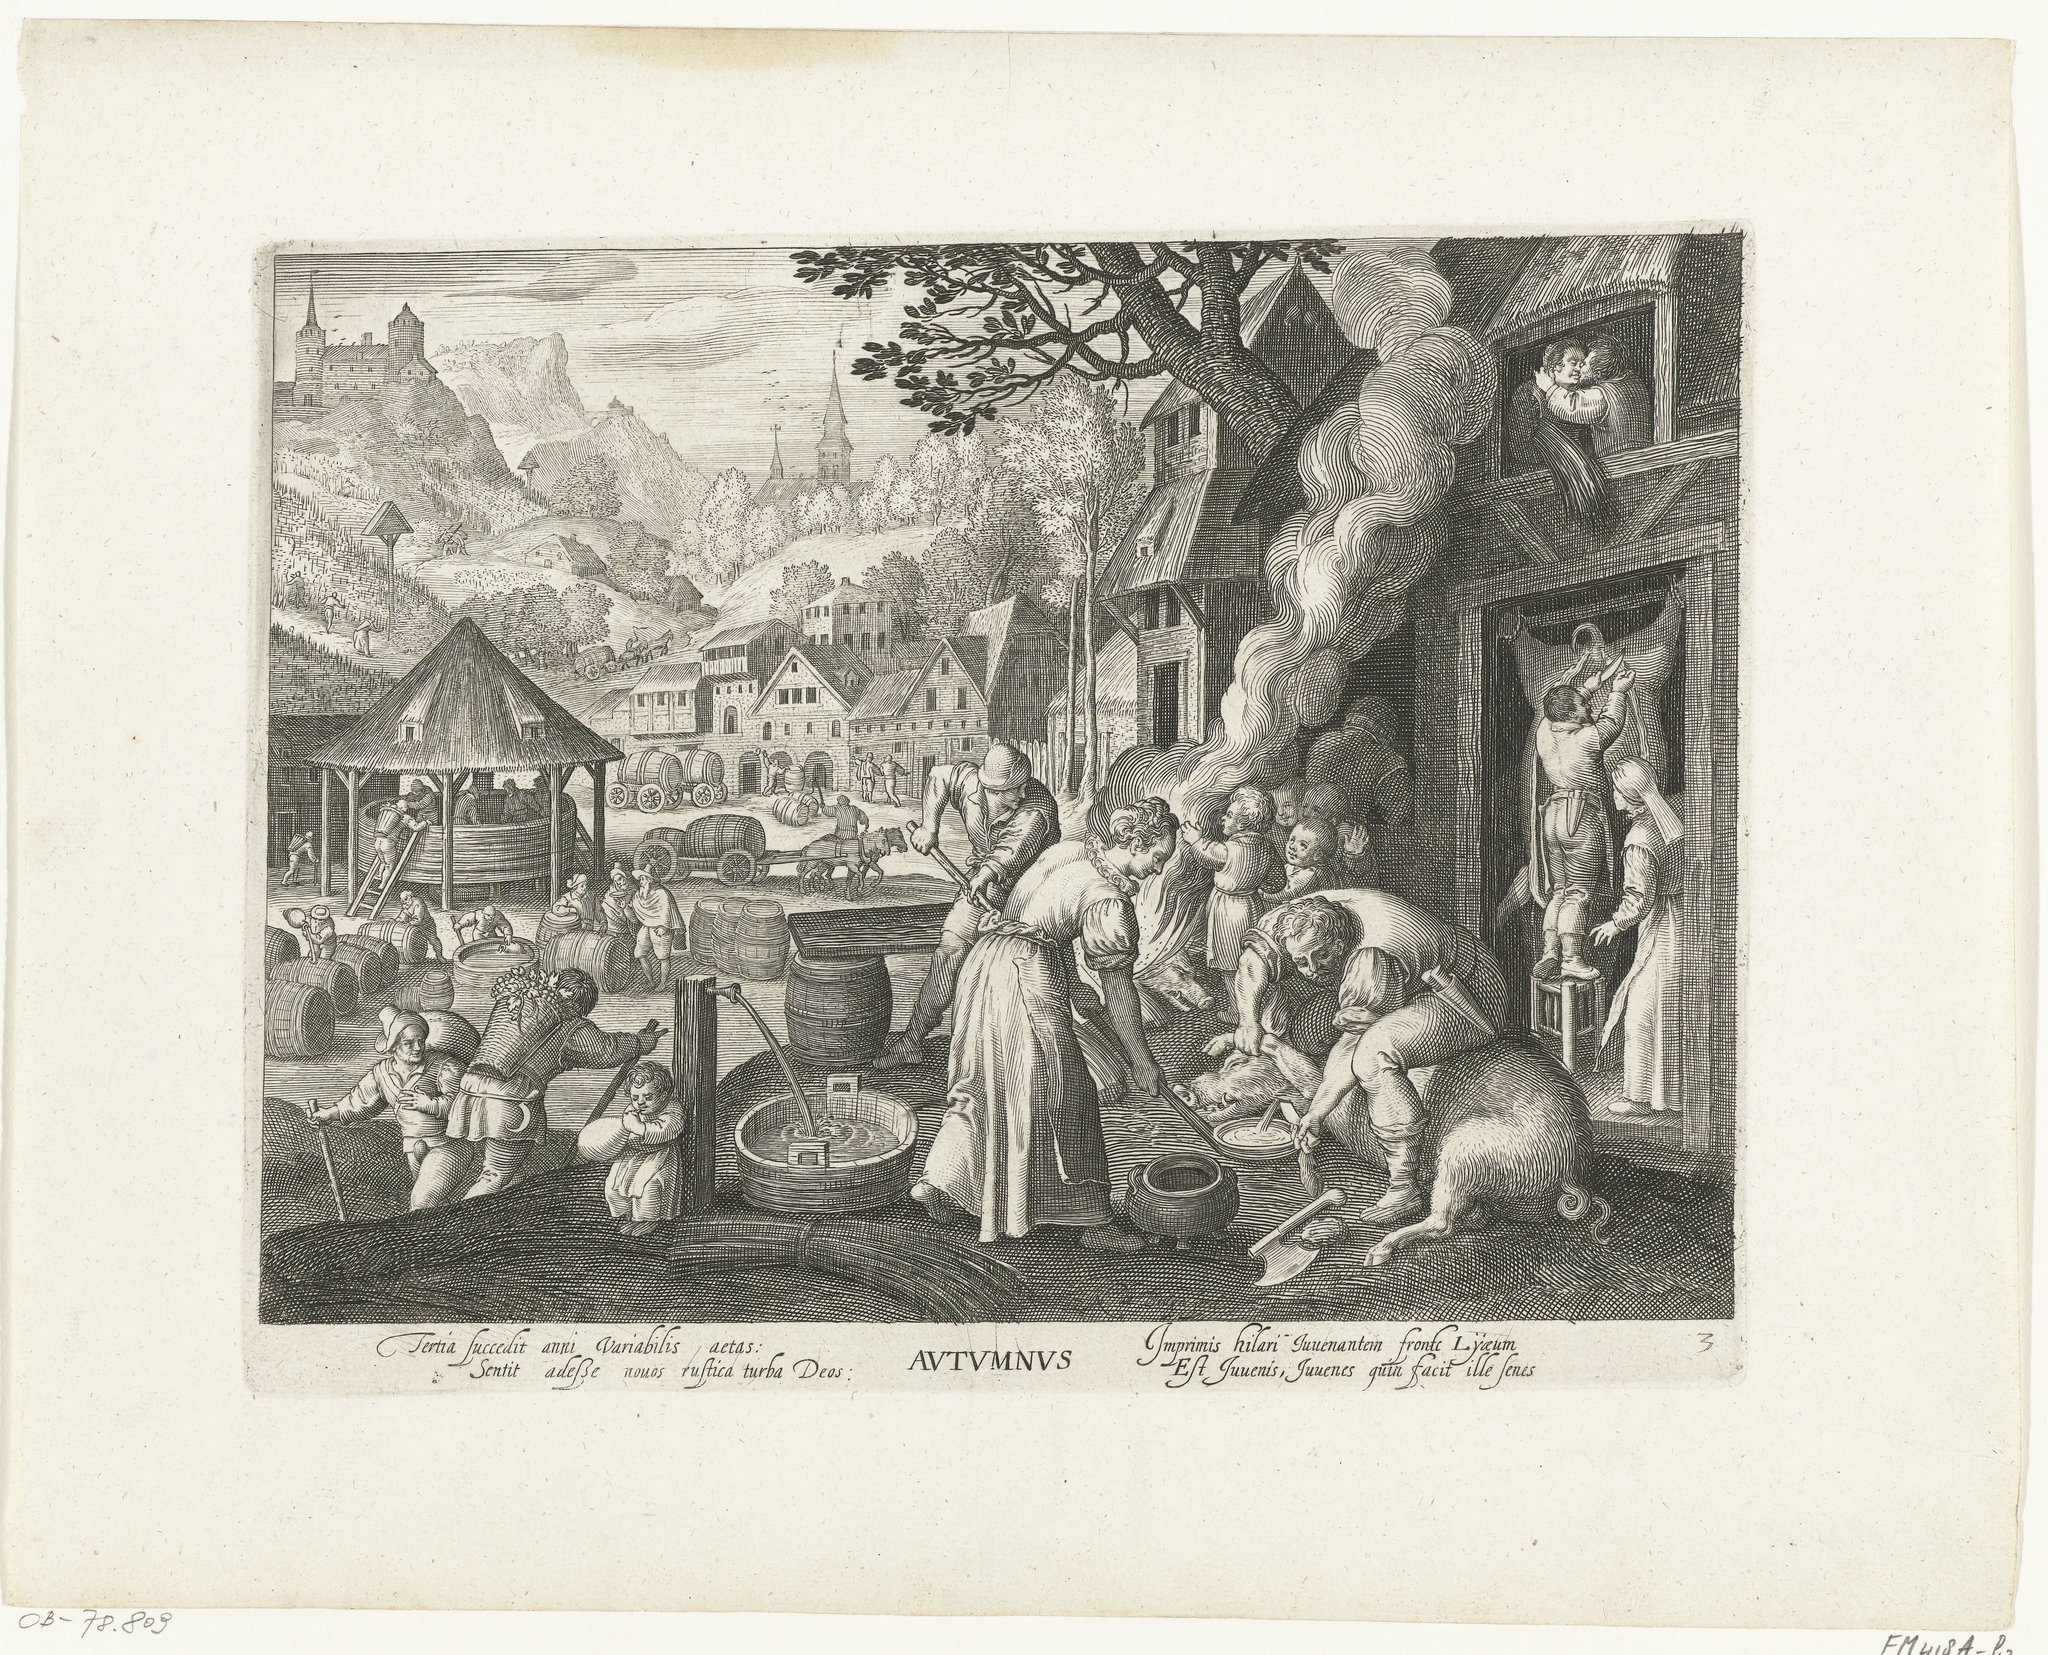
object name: print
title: Autumnus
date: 1581-1599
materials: paper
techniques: engraving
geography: amsterdam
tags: autumn ~ human activities (the four seasons of the year), slaughtered ox or pig, vintage, grape harvest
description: Het seizoen Herfst. Bij een boerderij wordt een varken geslacht, links druivenoogst en de productie van wijn. Onderschrift van 4 regels in het Latijn. Genummerd: 3.